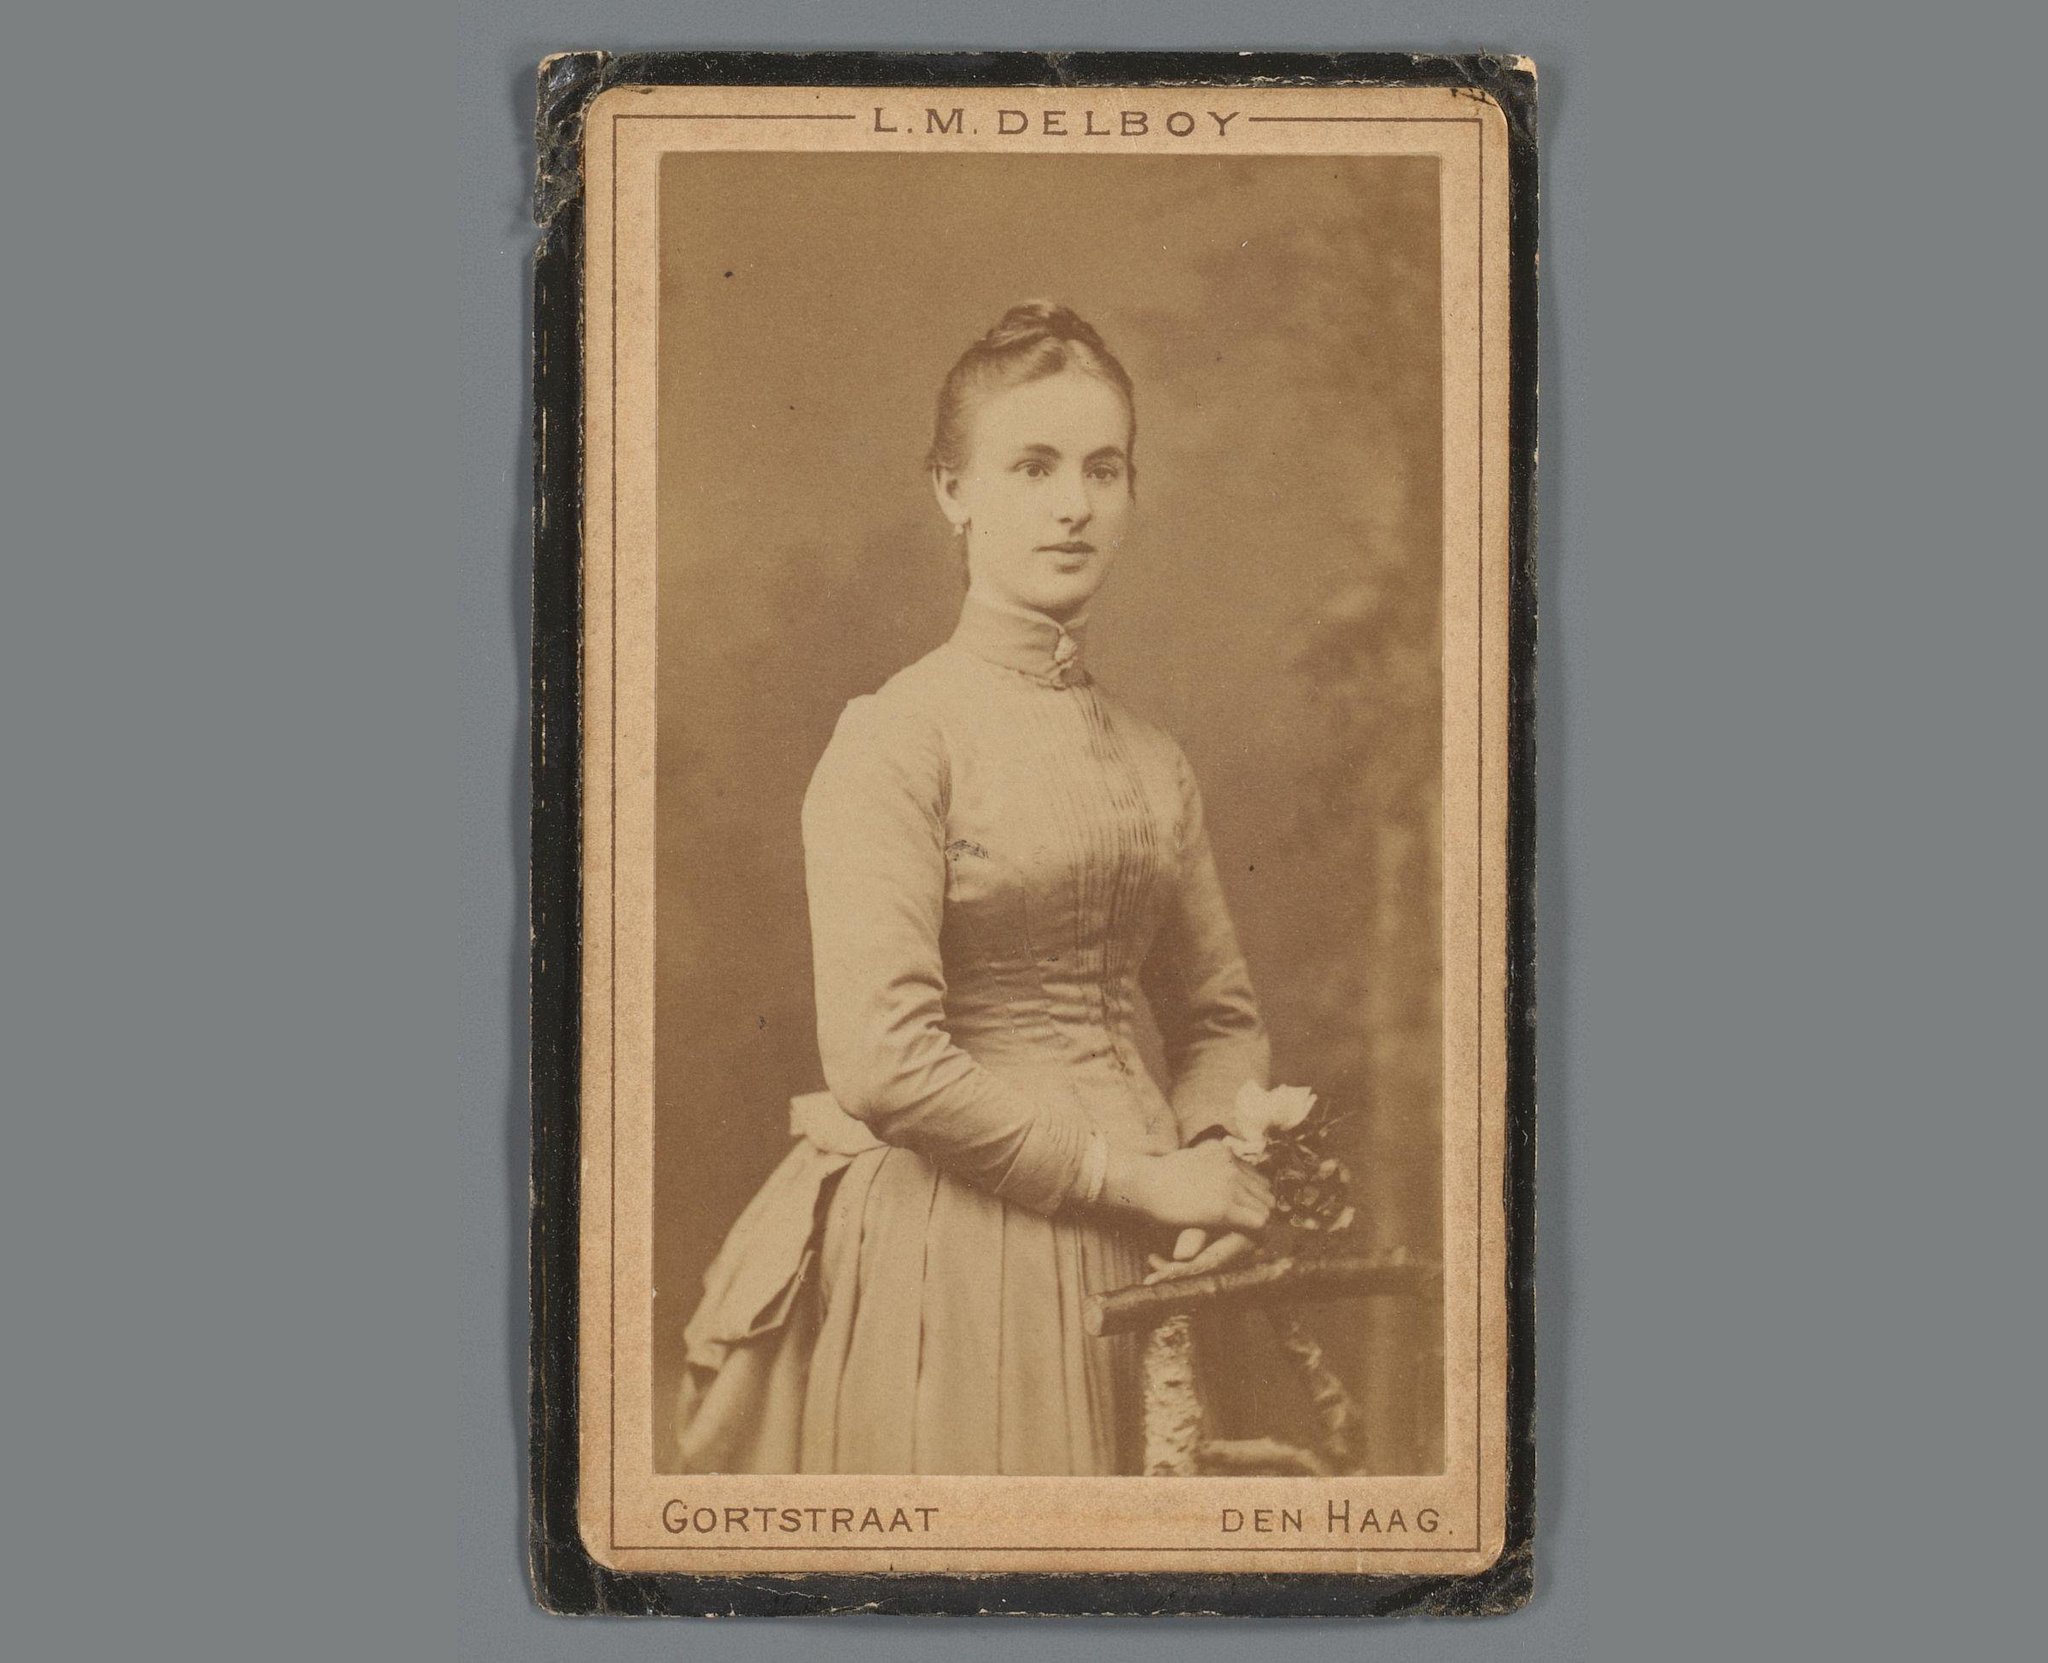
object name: prayer card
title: Portret van Petronella te Pas op bidprent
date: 1891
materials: cardboard, paper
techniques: albumen print, letterpress printing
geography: the hague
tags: the hague, adolescent, young woman, maiden, historical persons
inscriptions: inscription: ‘Bid voor de ziel van zaliger/ Petronella te Pas. (...) R.I.P./ A.N. Govers, Westeinde 6a, den Haag.’, inscription: ‘L.M. Delboy/ Gortstraat den Haag.’